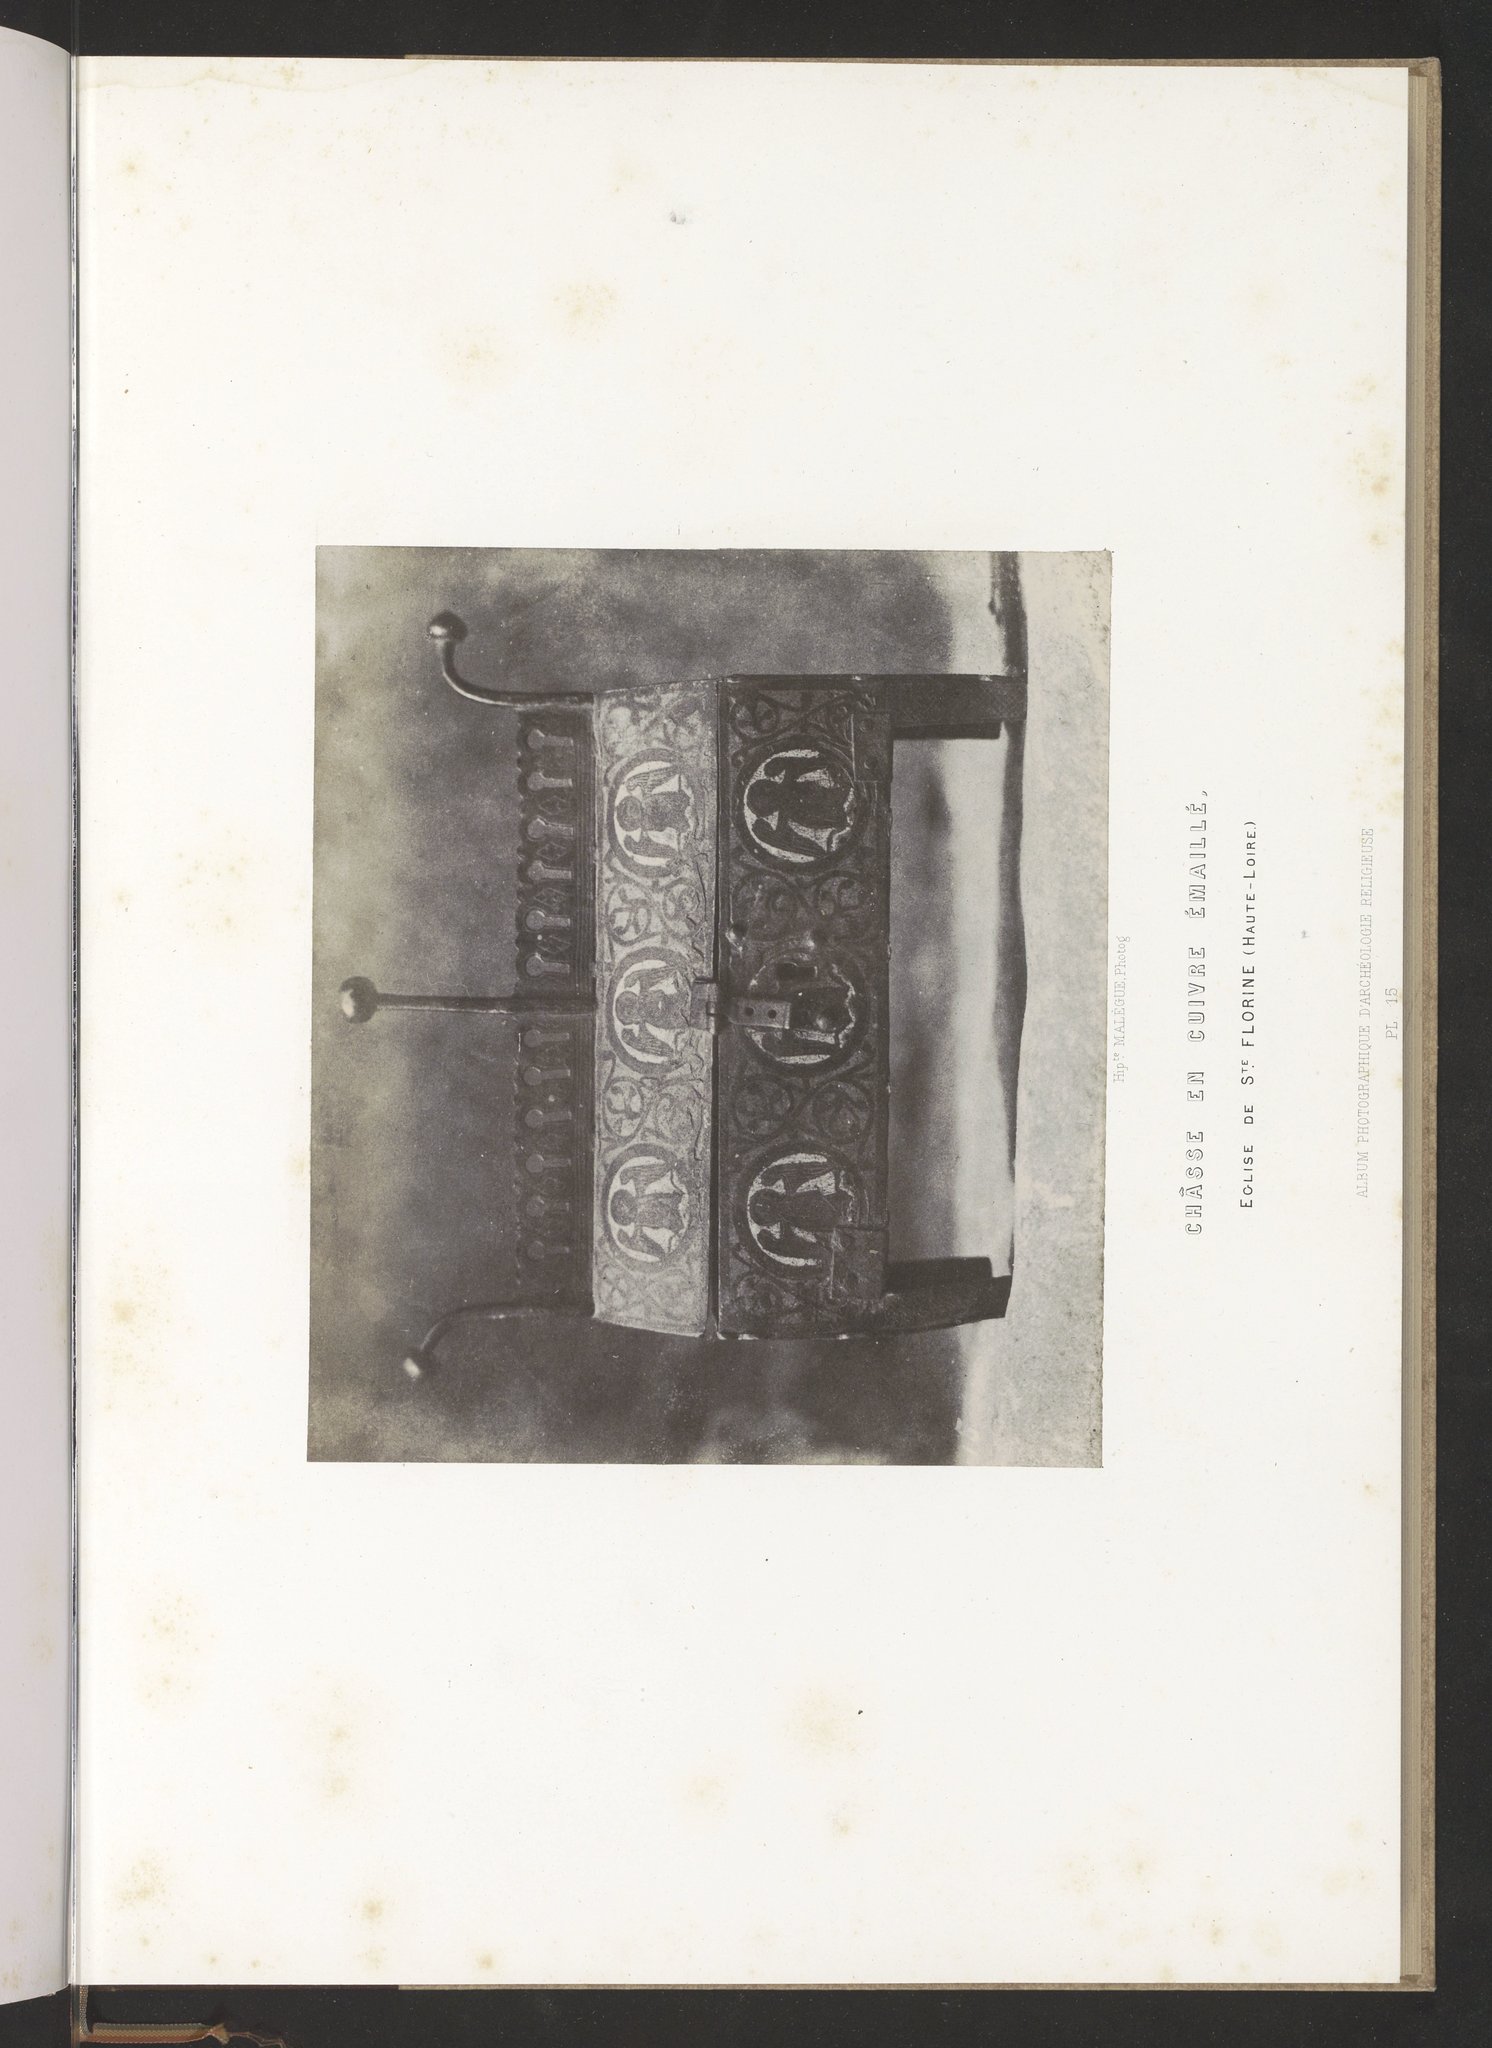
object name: photograph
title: Châsse en cuivre emaillé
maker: hippolyte malègue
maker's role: archeoloog, fotograaf, schrijver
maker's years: 1825-1901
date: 1850-1857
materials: photographic support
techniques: salted paper print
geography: france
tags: relics (and reliquaries)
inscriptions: inscription: ‘eglise de Ste. Florine (Haute-Loire.)’, number: ‘PL. 15.’